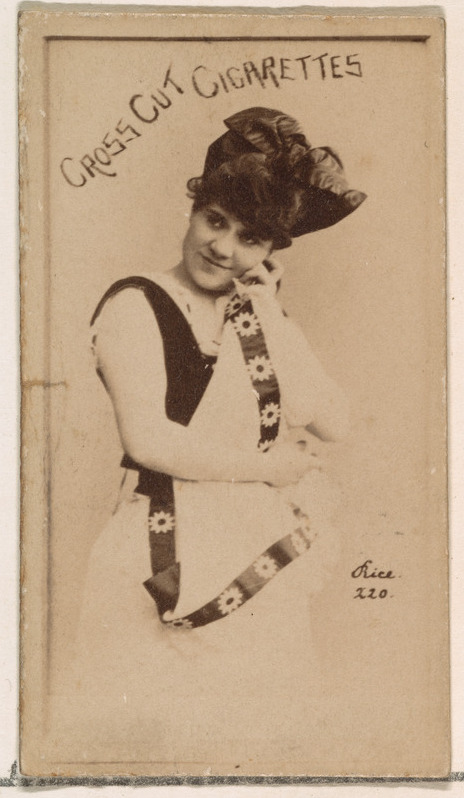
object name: print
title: Card Number 220, Fanny Rice, from the Actors and Actresses series (N145-1) issued by Duke Sons & Co. to promote Cross Cut Cigarettes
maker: w. duke, sons & co.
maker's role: publisher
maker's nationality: american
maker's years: 1870-1920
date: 1880-1889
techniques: albumen silver print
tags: portraits,women,actresses